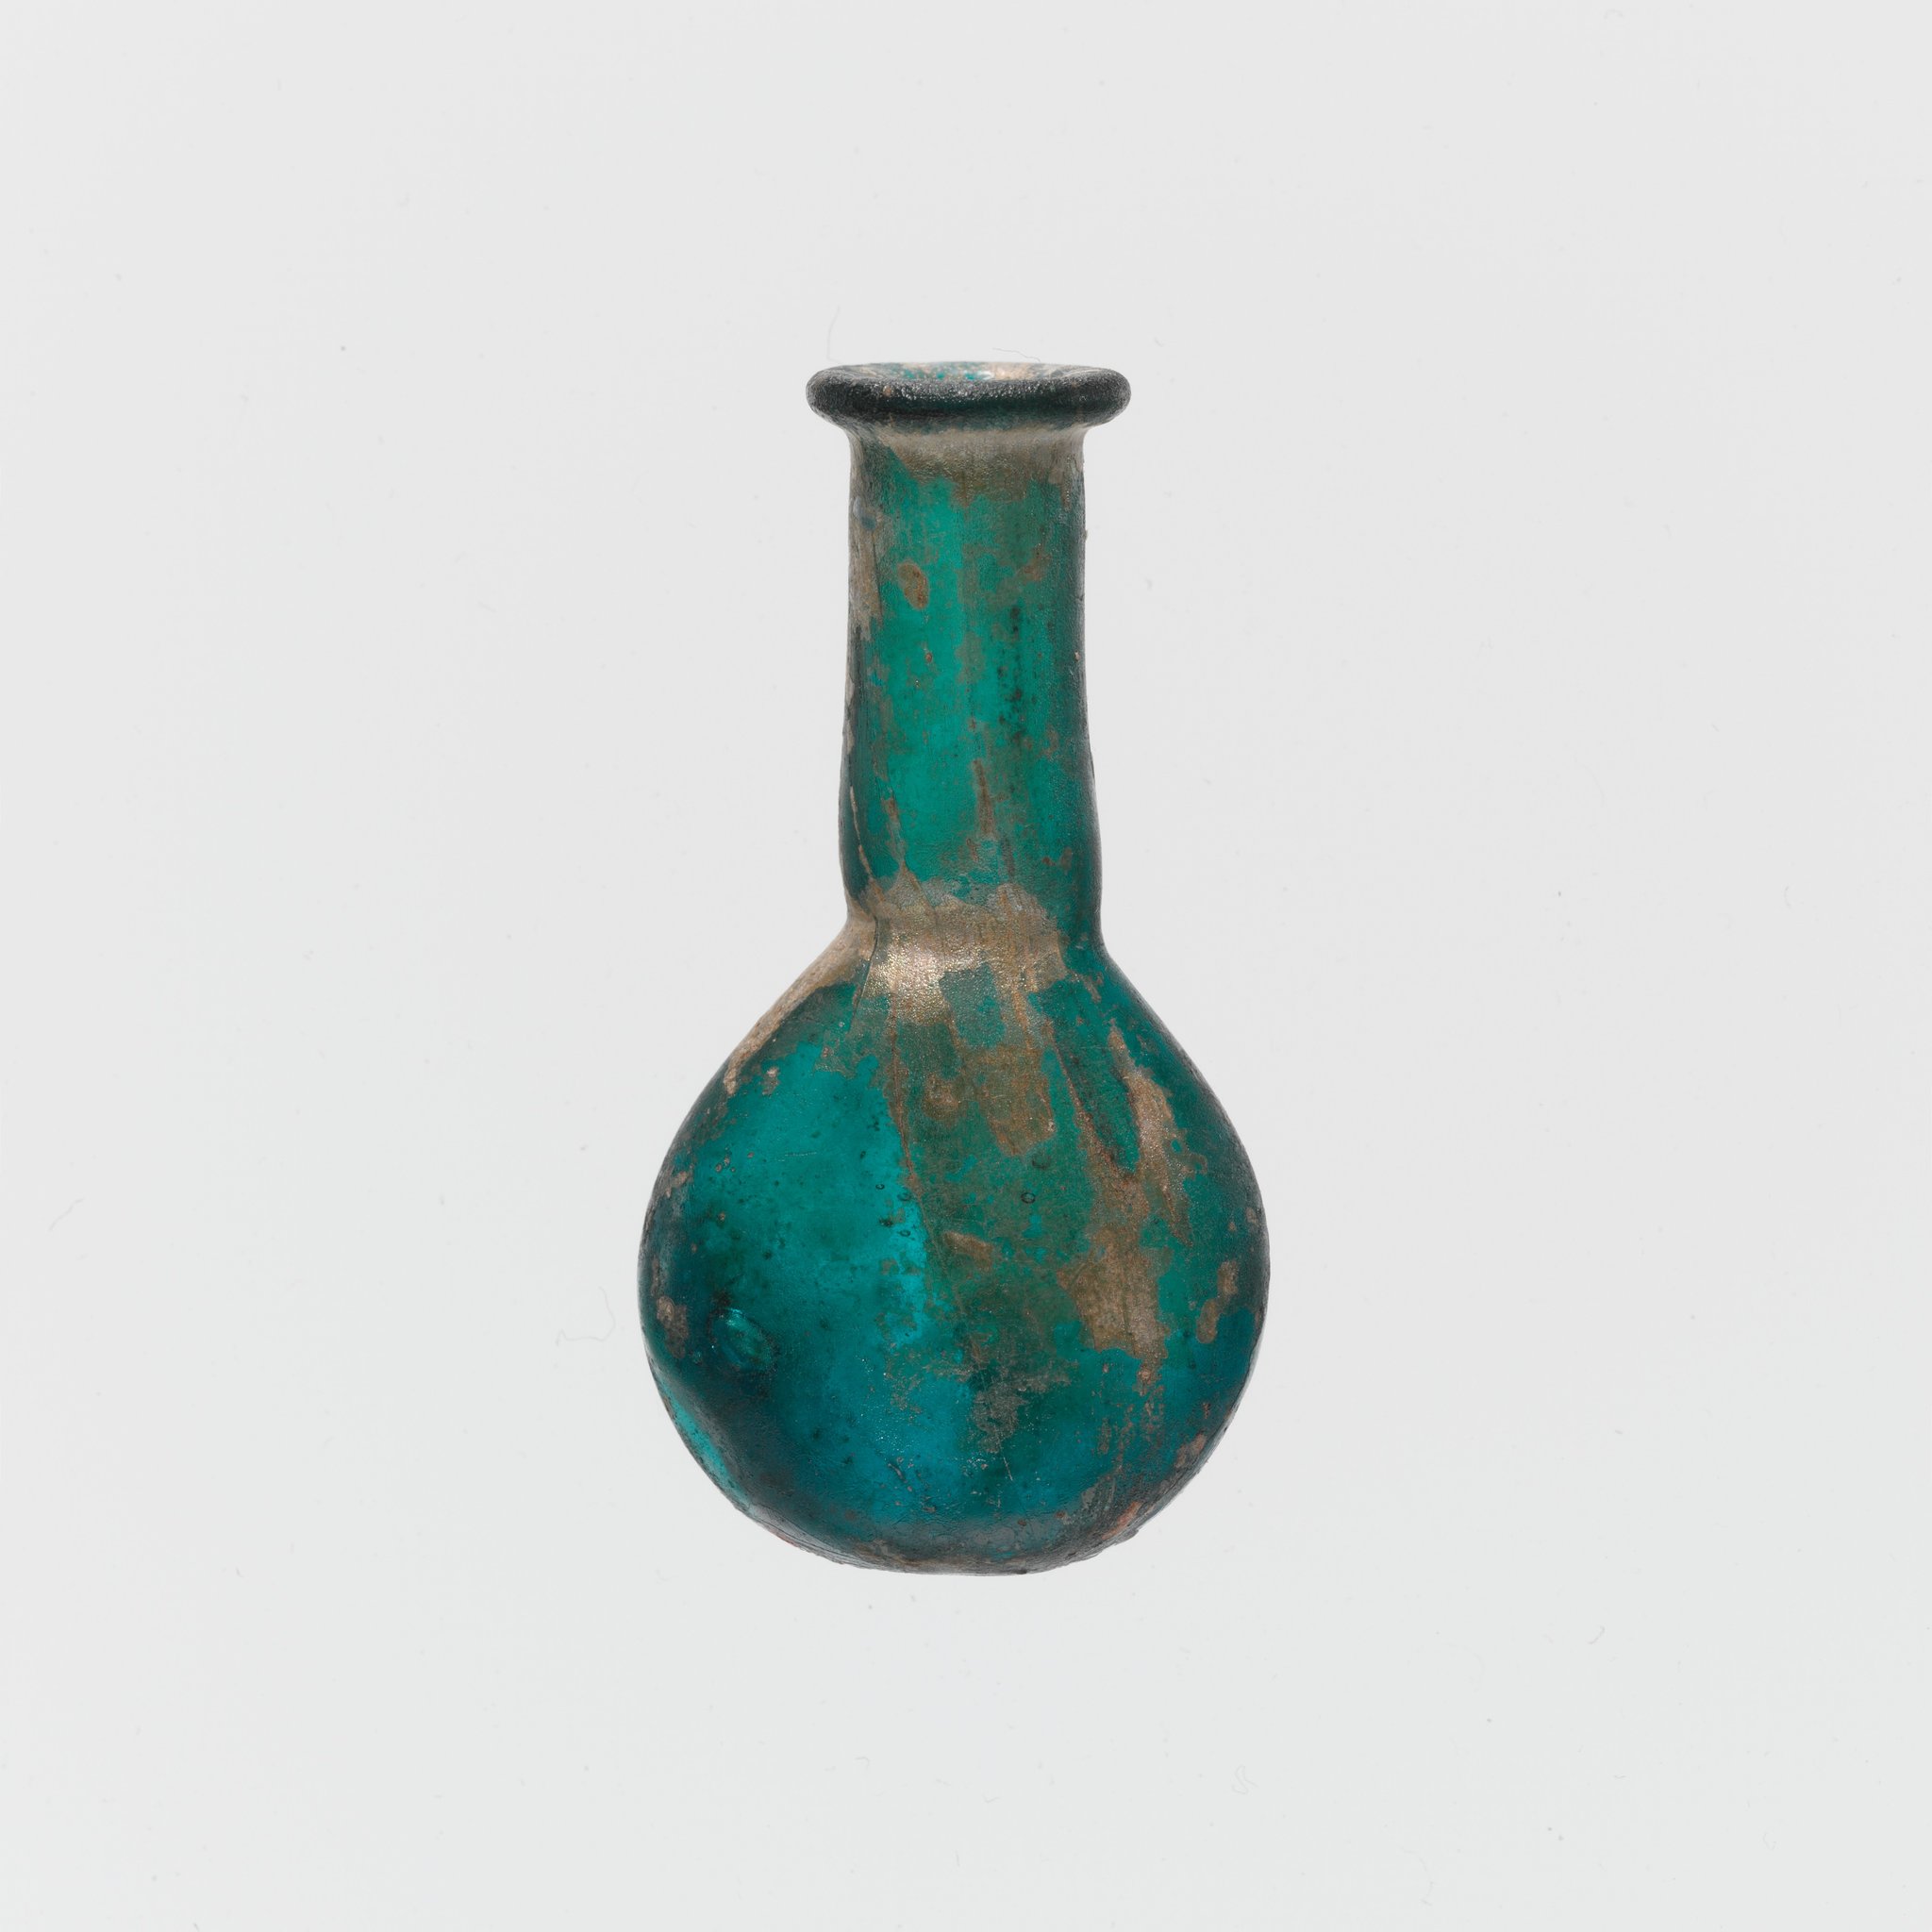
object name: lentoid perfume bottle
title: Glass perfume bottle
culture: roman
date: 1-100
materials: glass